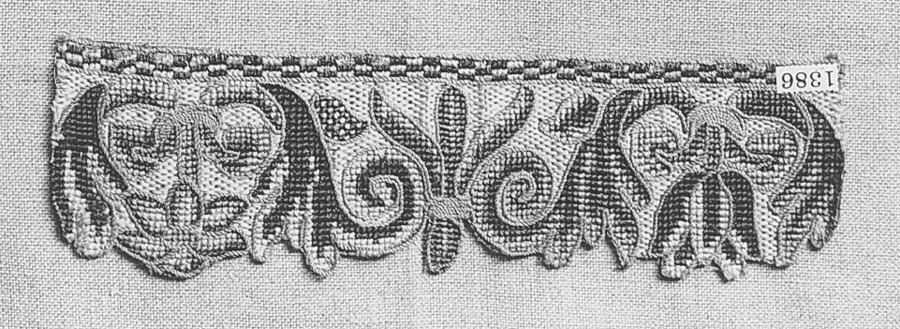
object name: border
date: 1601-1700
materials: canvas, silk